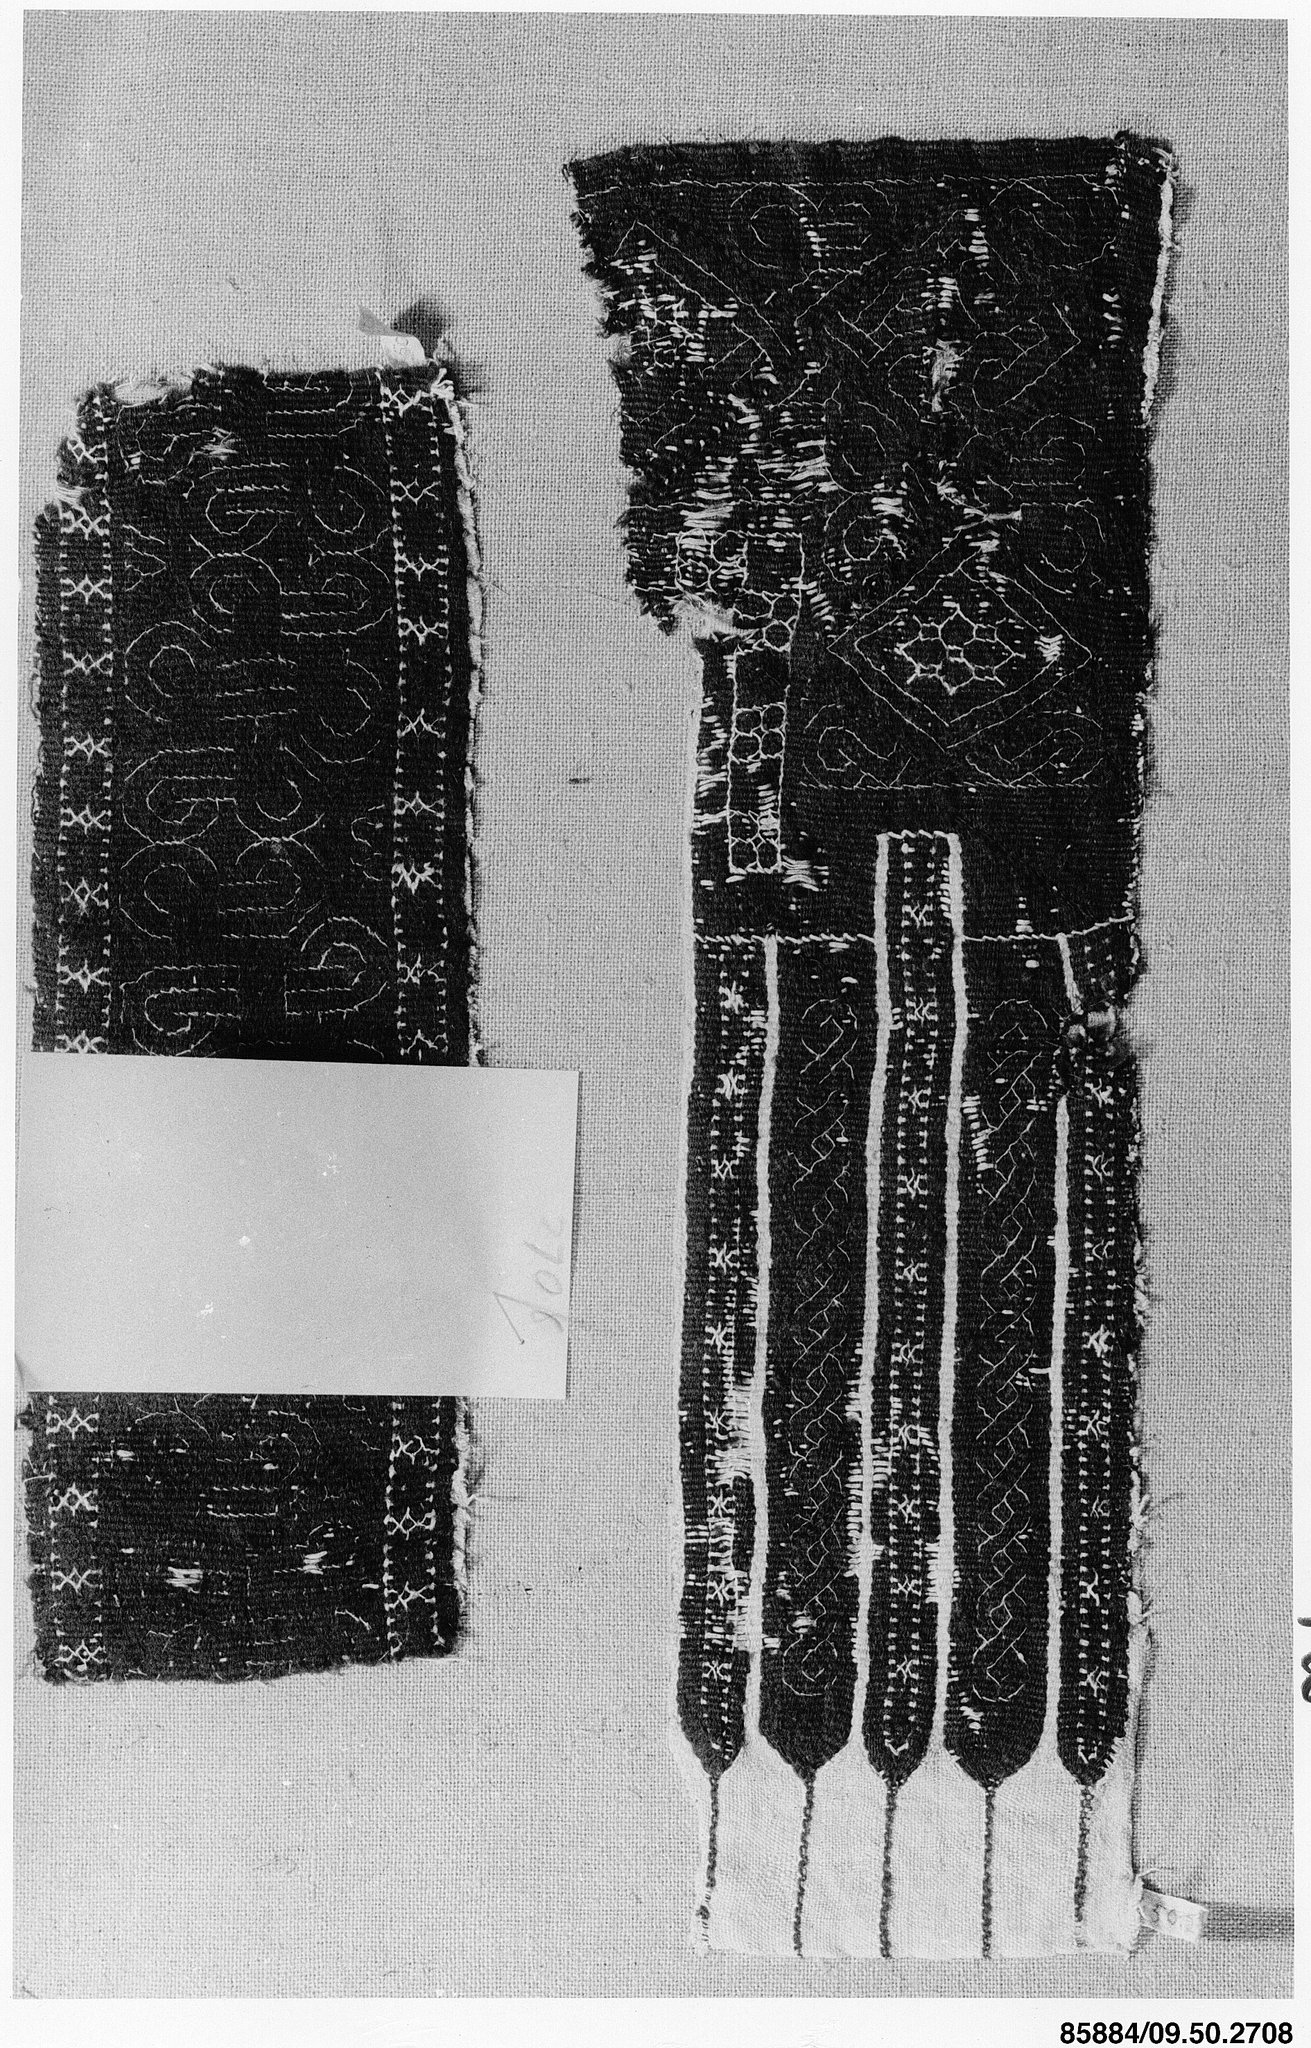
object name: shoulder band fragment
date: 301-500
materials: linen, wool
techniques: weave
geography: egypt